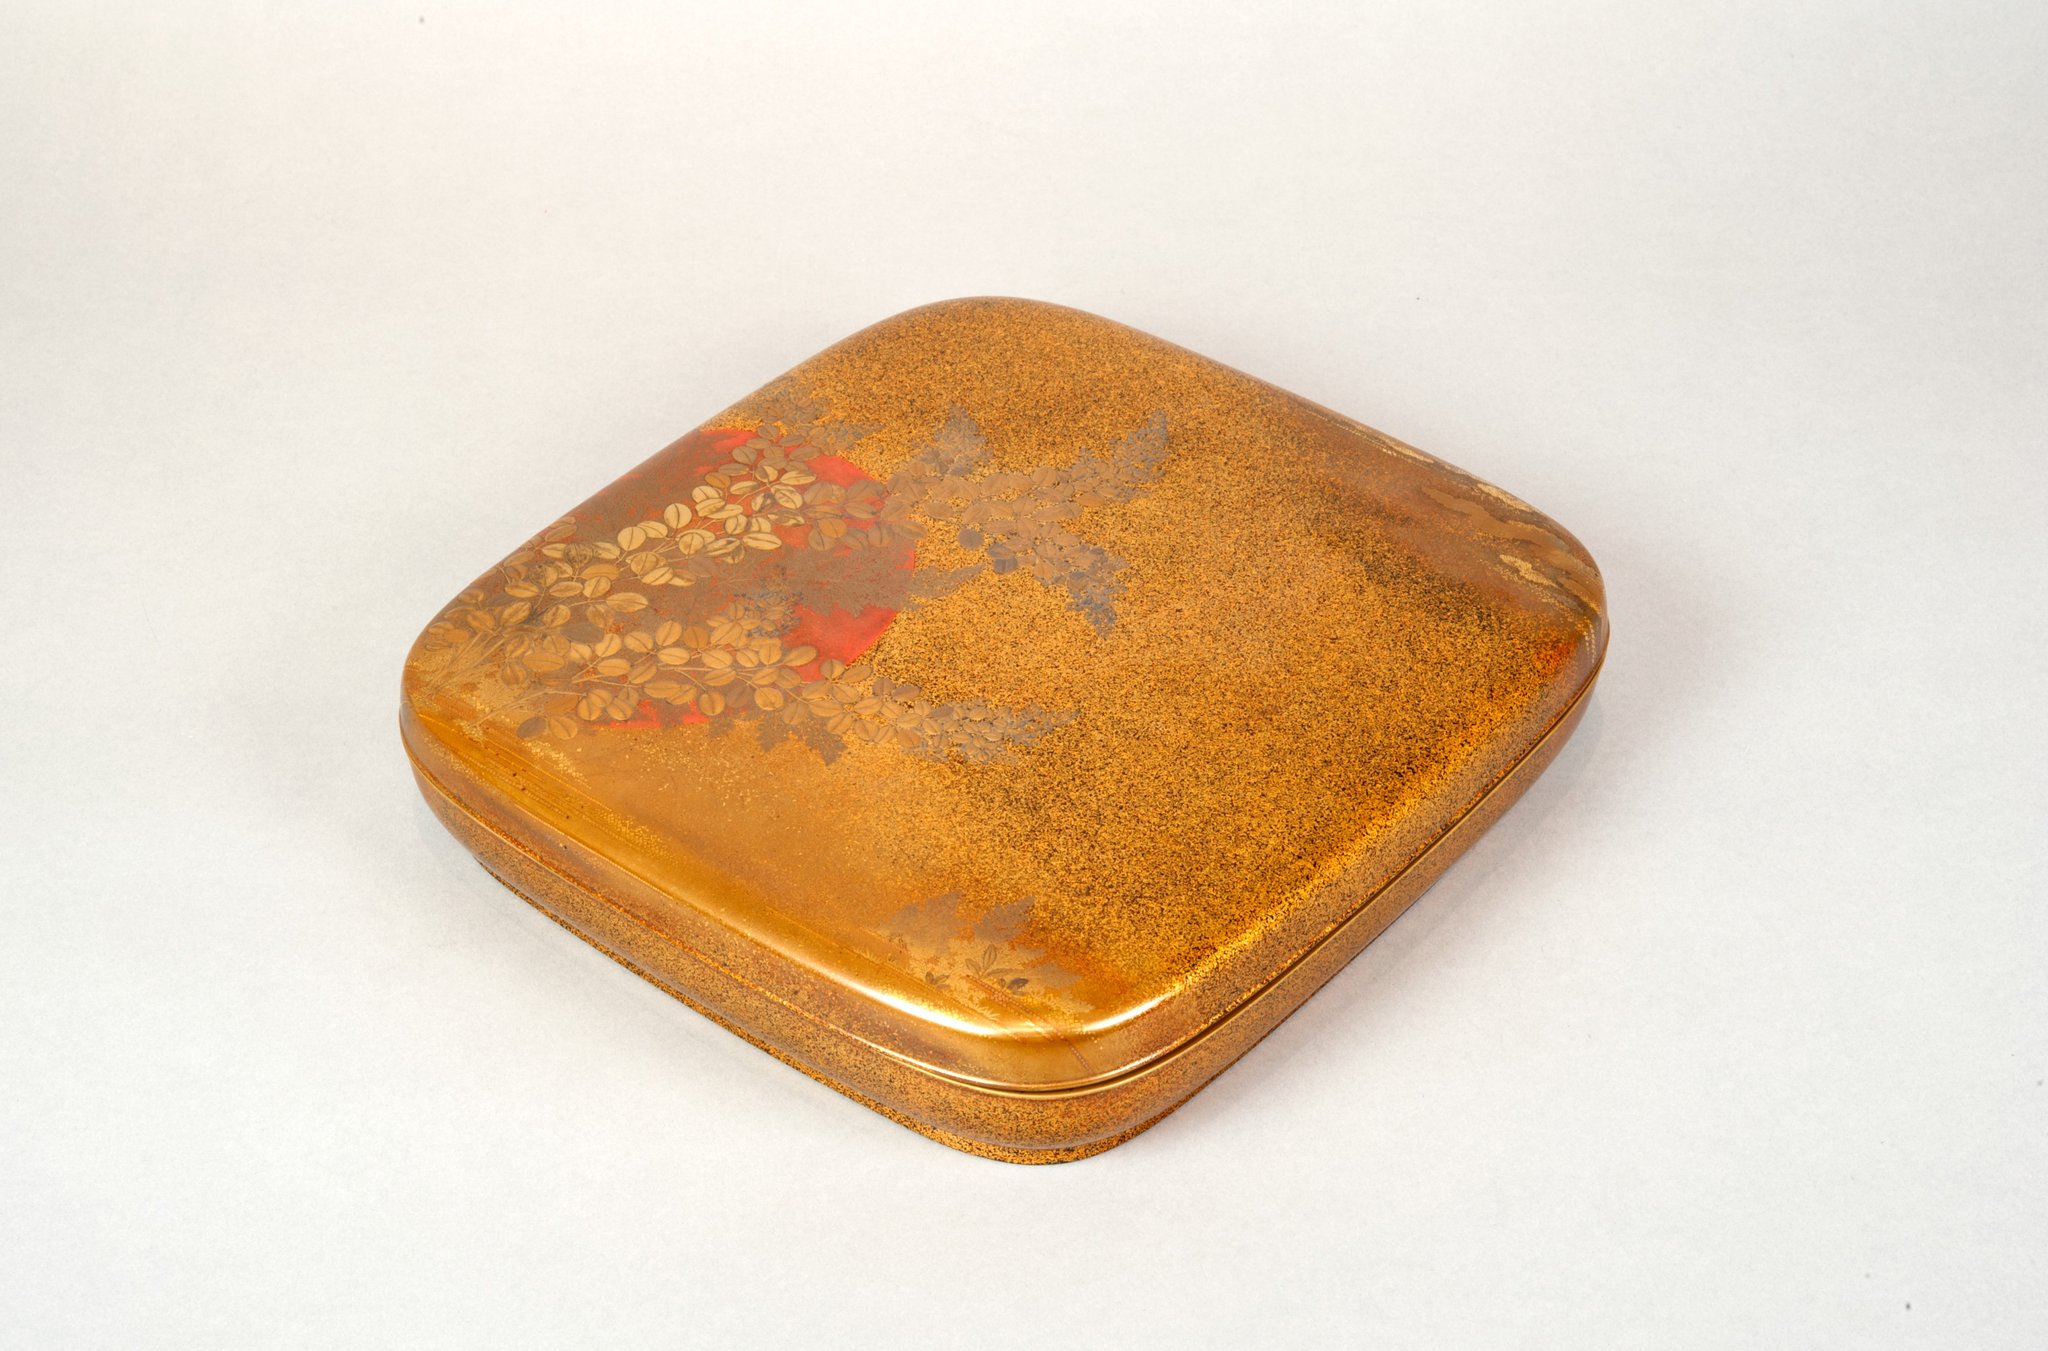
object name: writing box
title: Writing Box with Design of Flowering Bush Clover and Sun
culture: japanese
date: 1801-1850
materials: gold, gold foil, silver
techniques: cutting, hiramakie, maki-e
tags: sun,plants